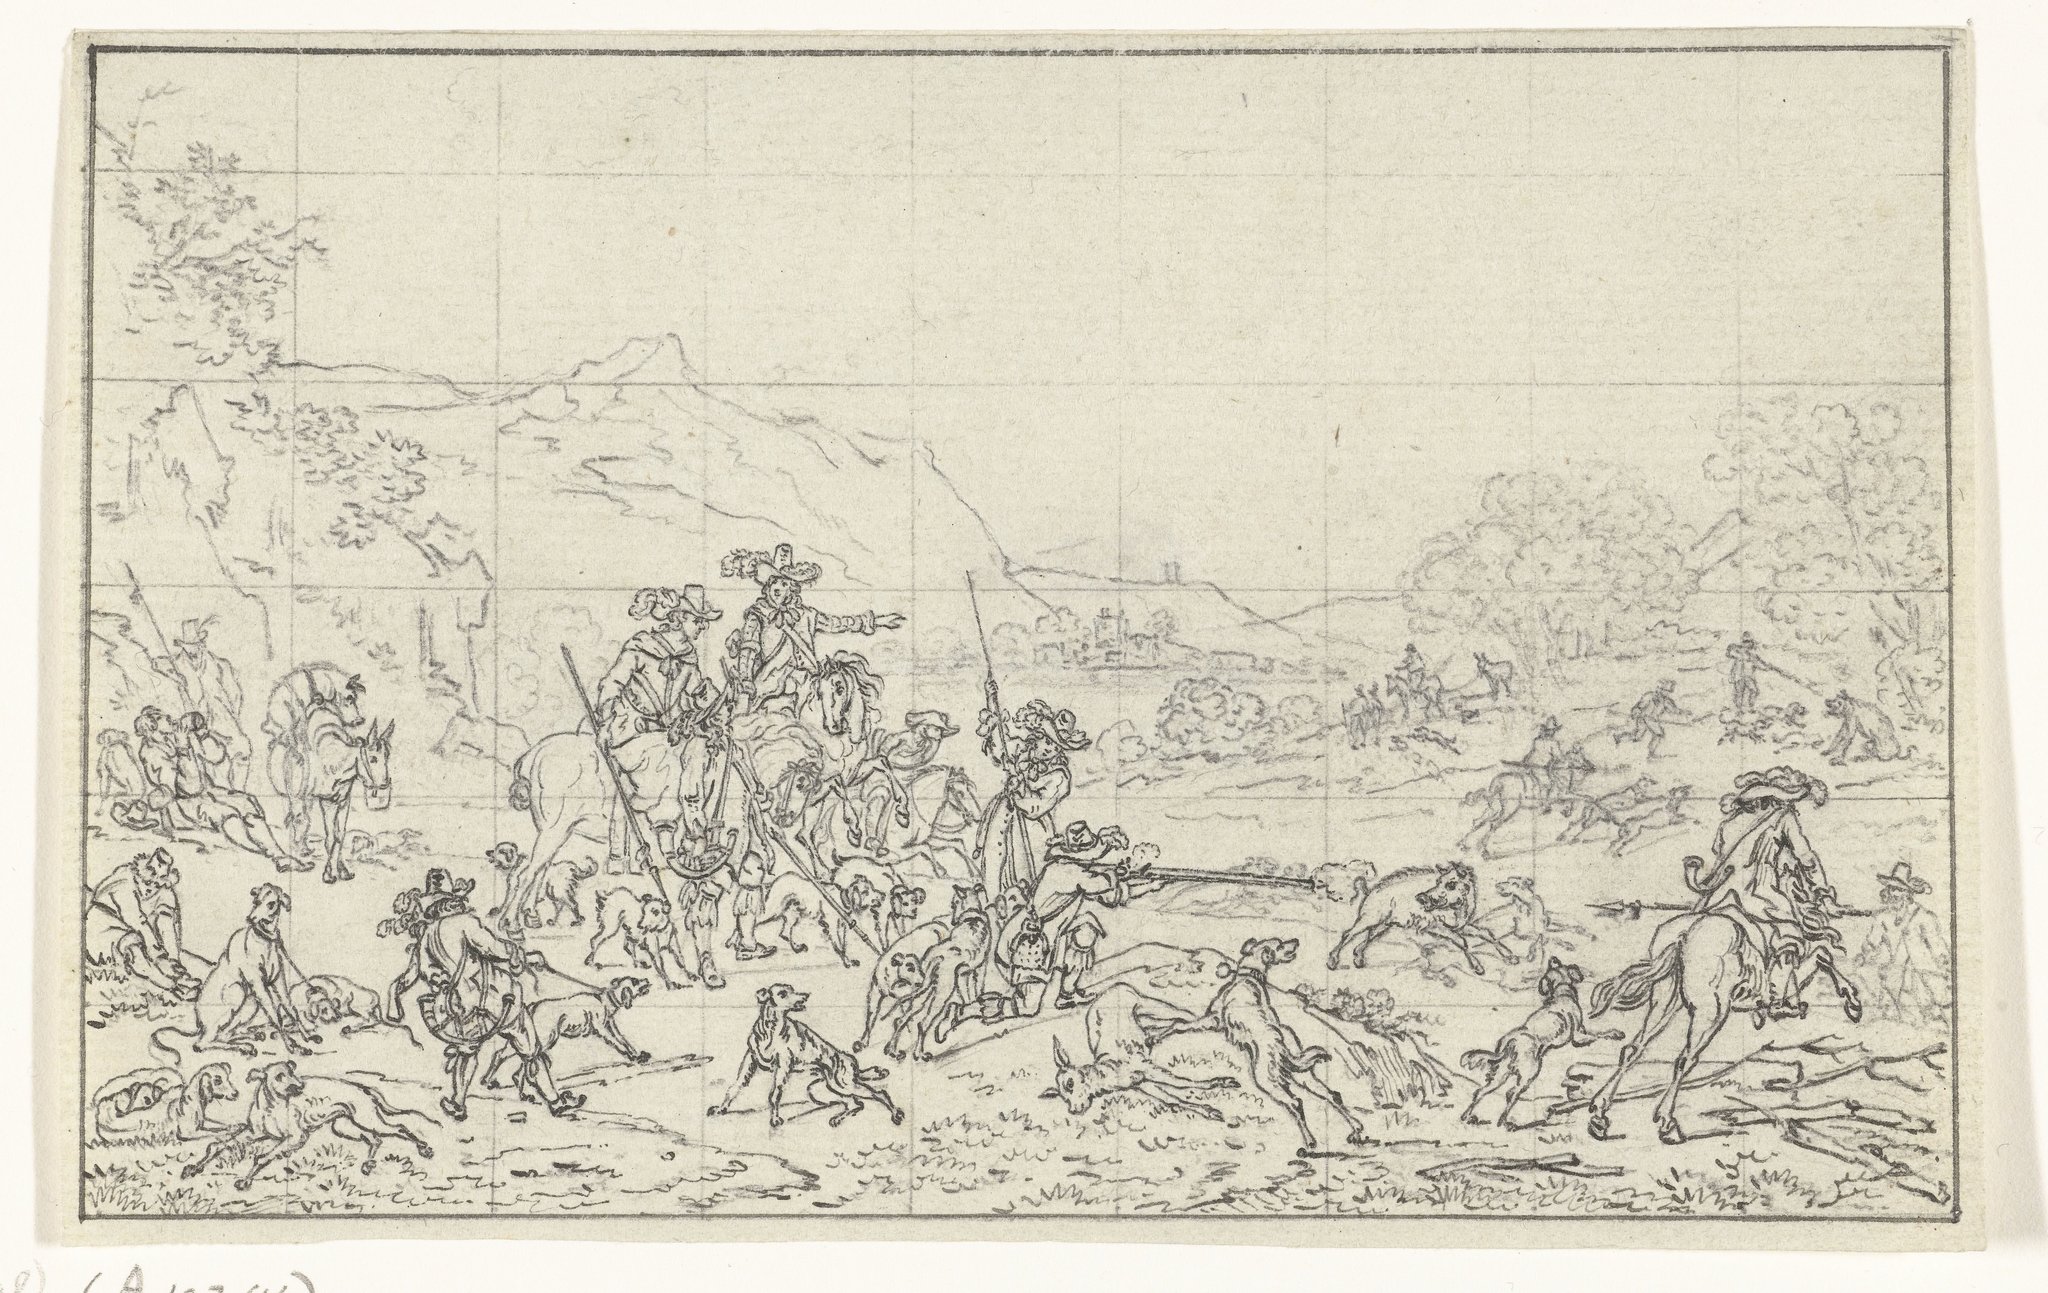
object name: drawing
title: Zwijnenjacht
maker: joannes bemme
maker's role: print maker, printer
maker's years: 1775-1841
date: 1800-1841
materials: ink, paper, pencil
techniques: pen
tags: hunting, chase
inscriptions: collector's mark: Lugt 2228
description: In een heuvelachtig landschap vindt een zwijnenjacht plaats. Mannen te paard en op de grond zijn bezig met de jacht. Jachthonden houden de zwijnen in bedwang. Links wordt de buit al op ezels geladen.